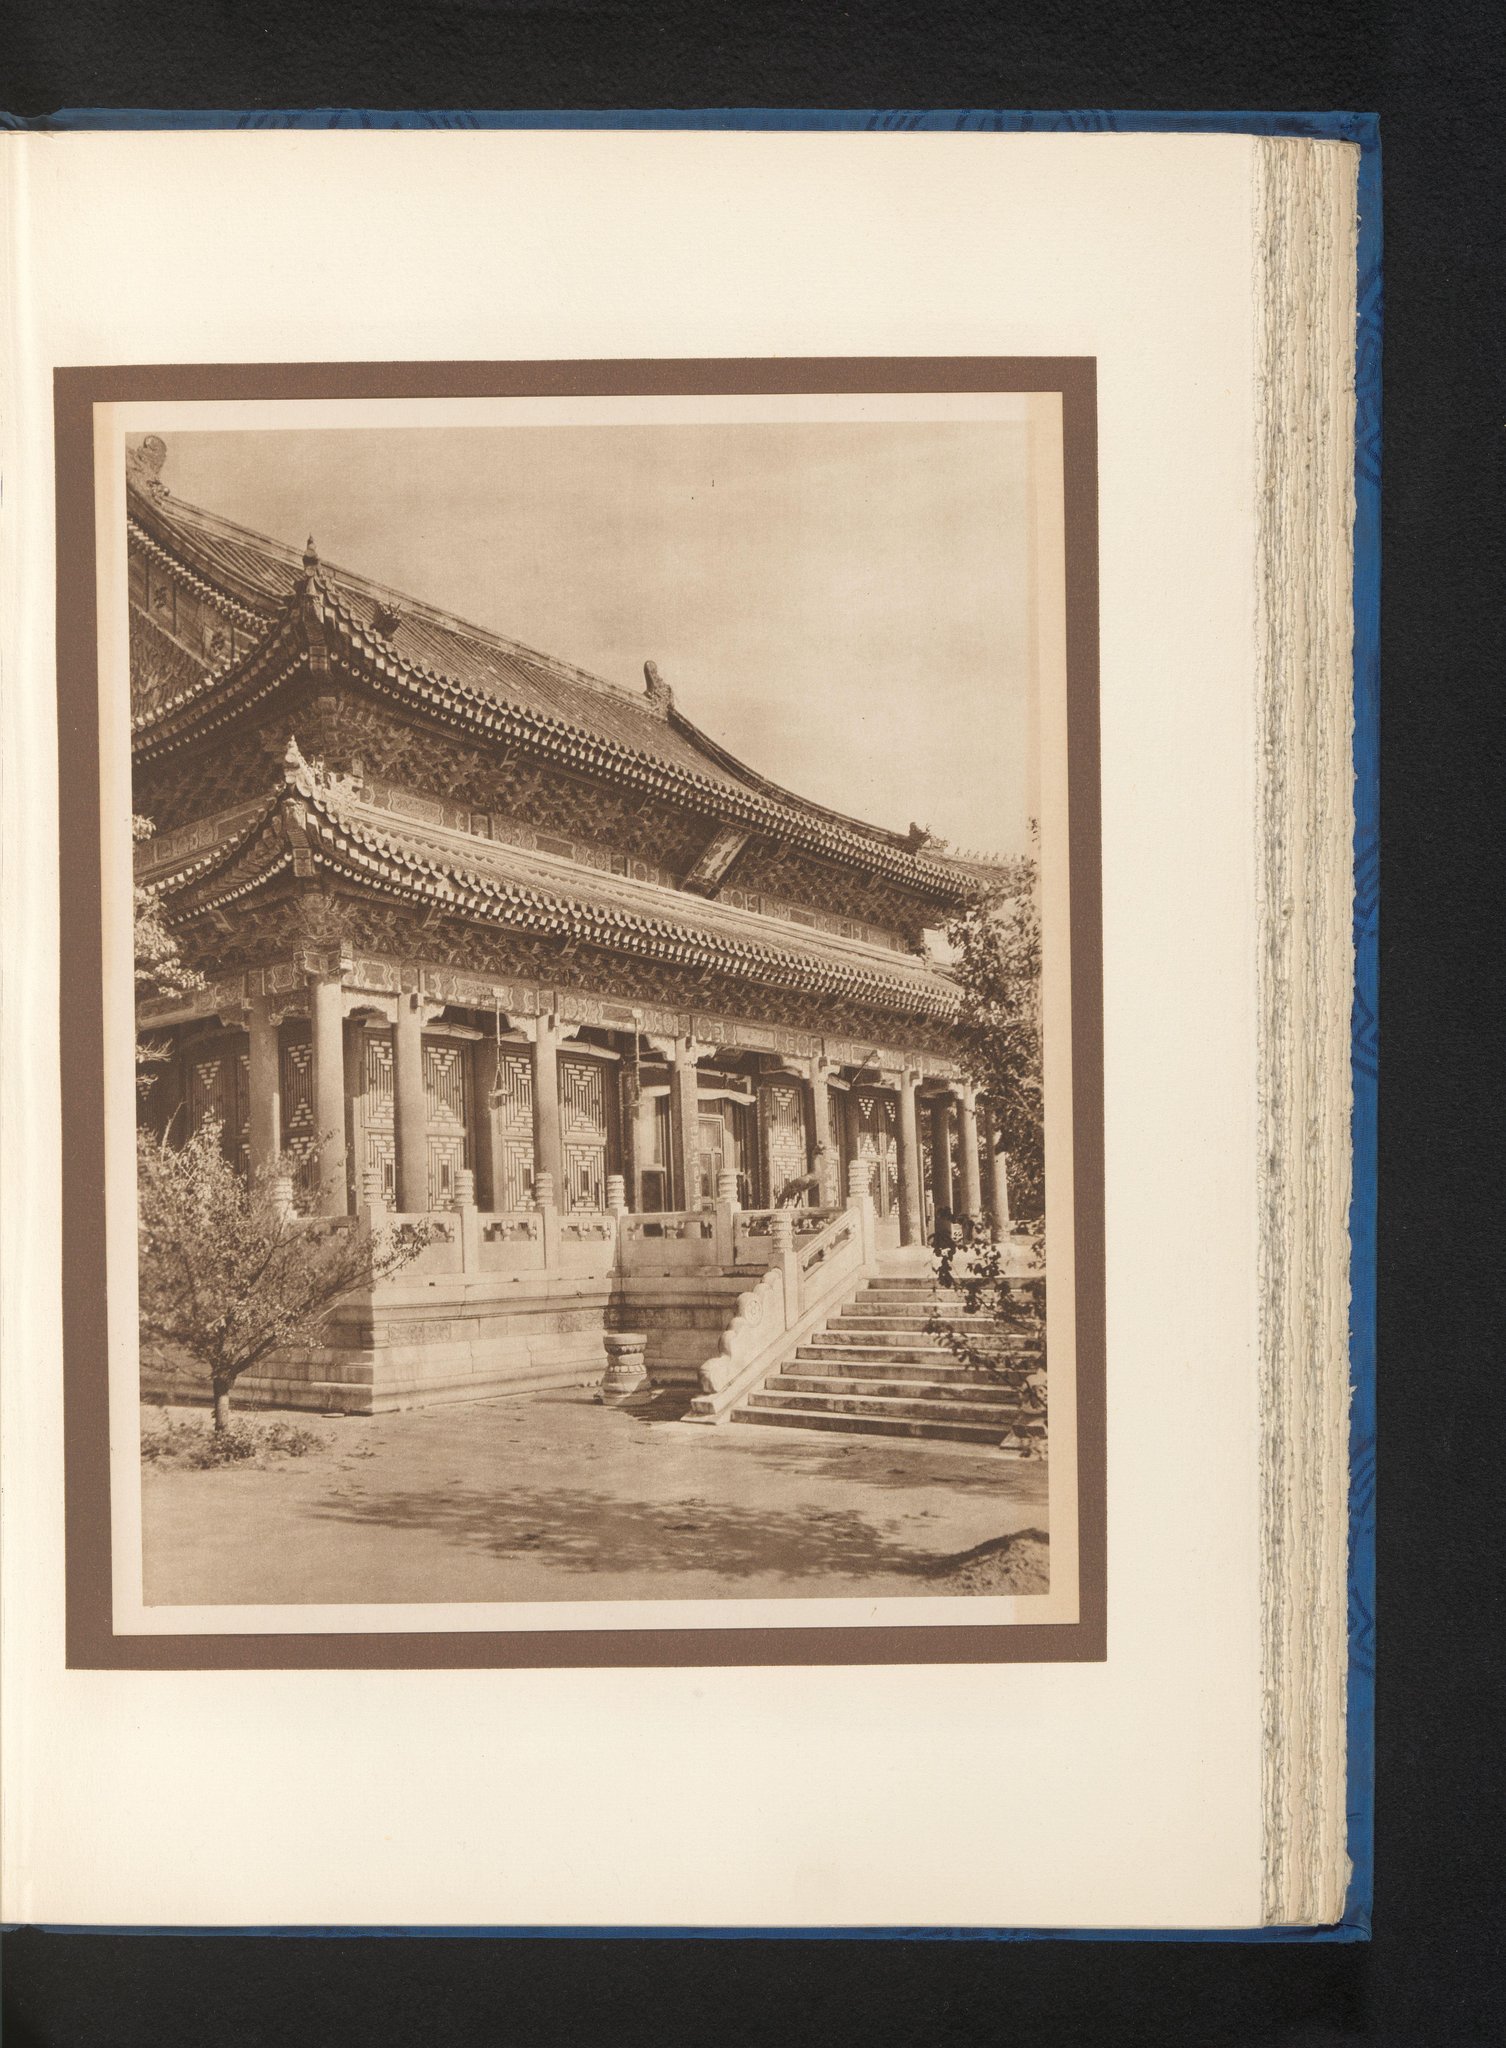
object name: photomechanical print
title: Zomerpaleis te Peking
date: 1915-1920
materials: paper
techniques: rotogravure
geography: beijing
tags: palace